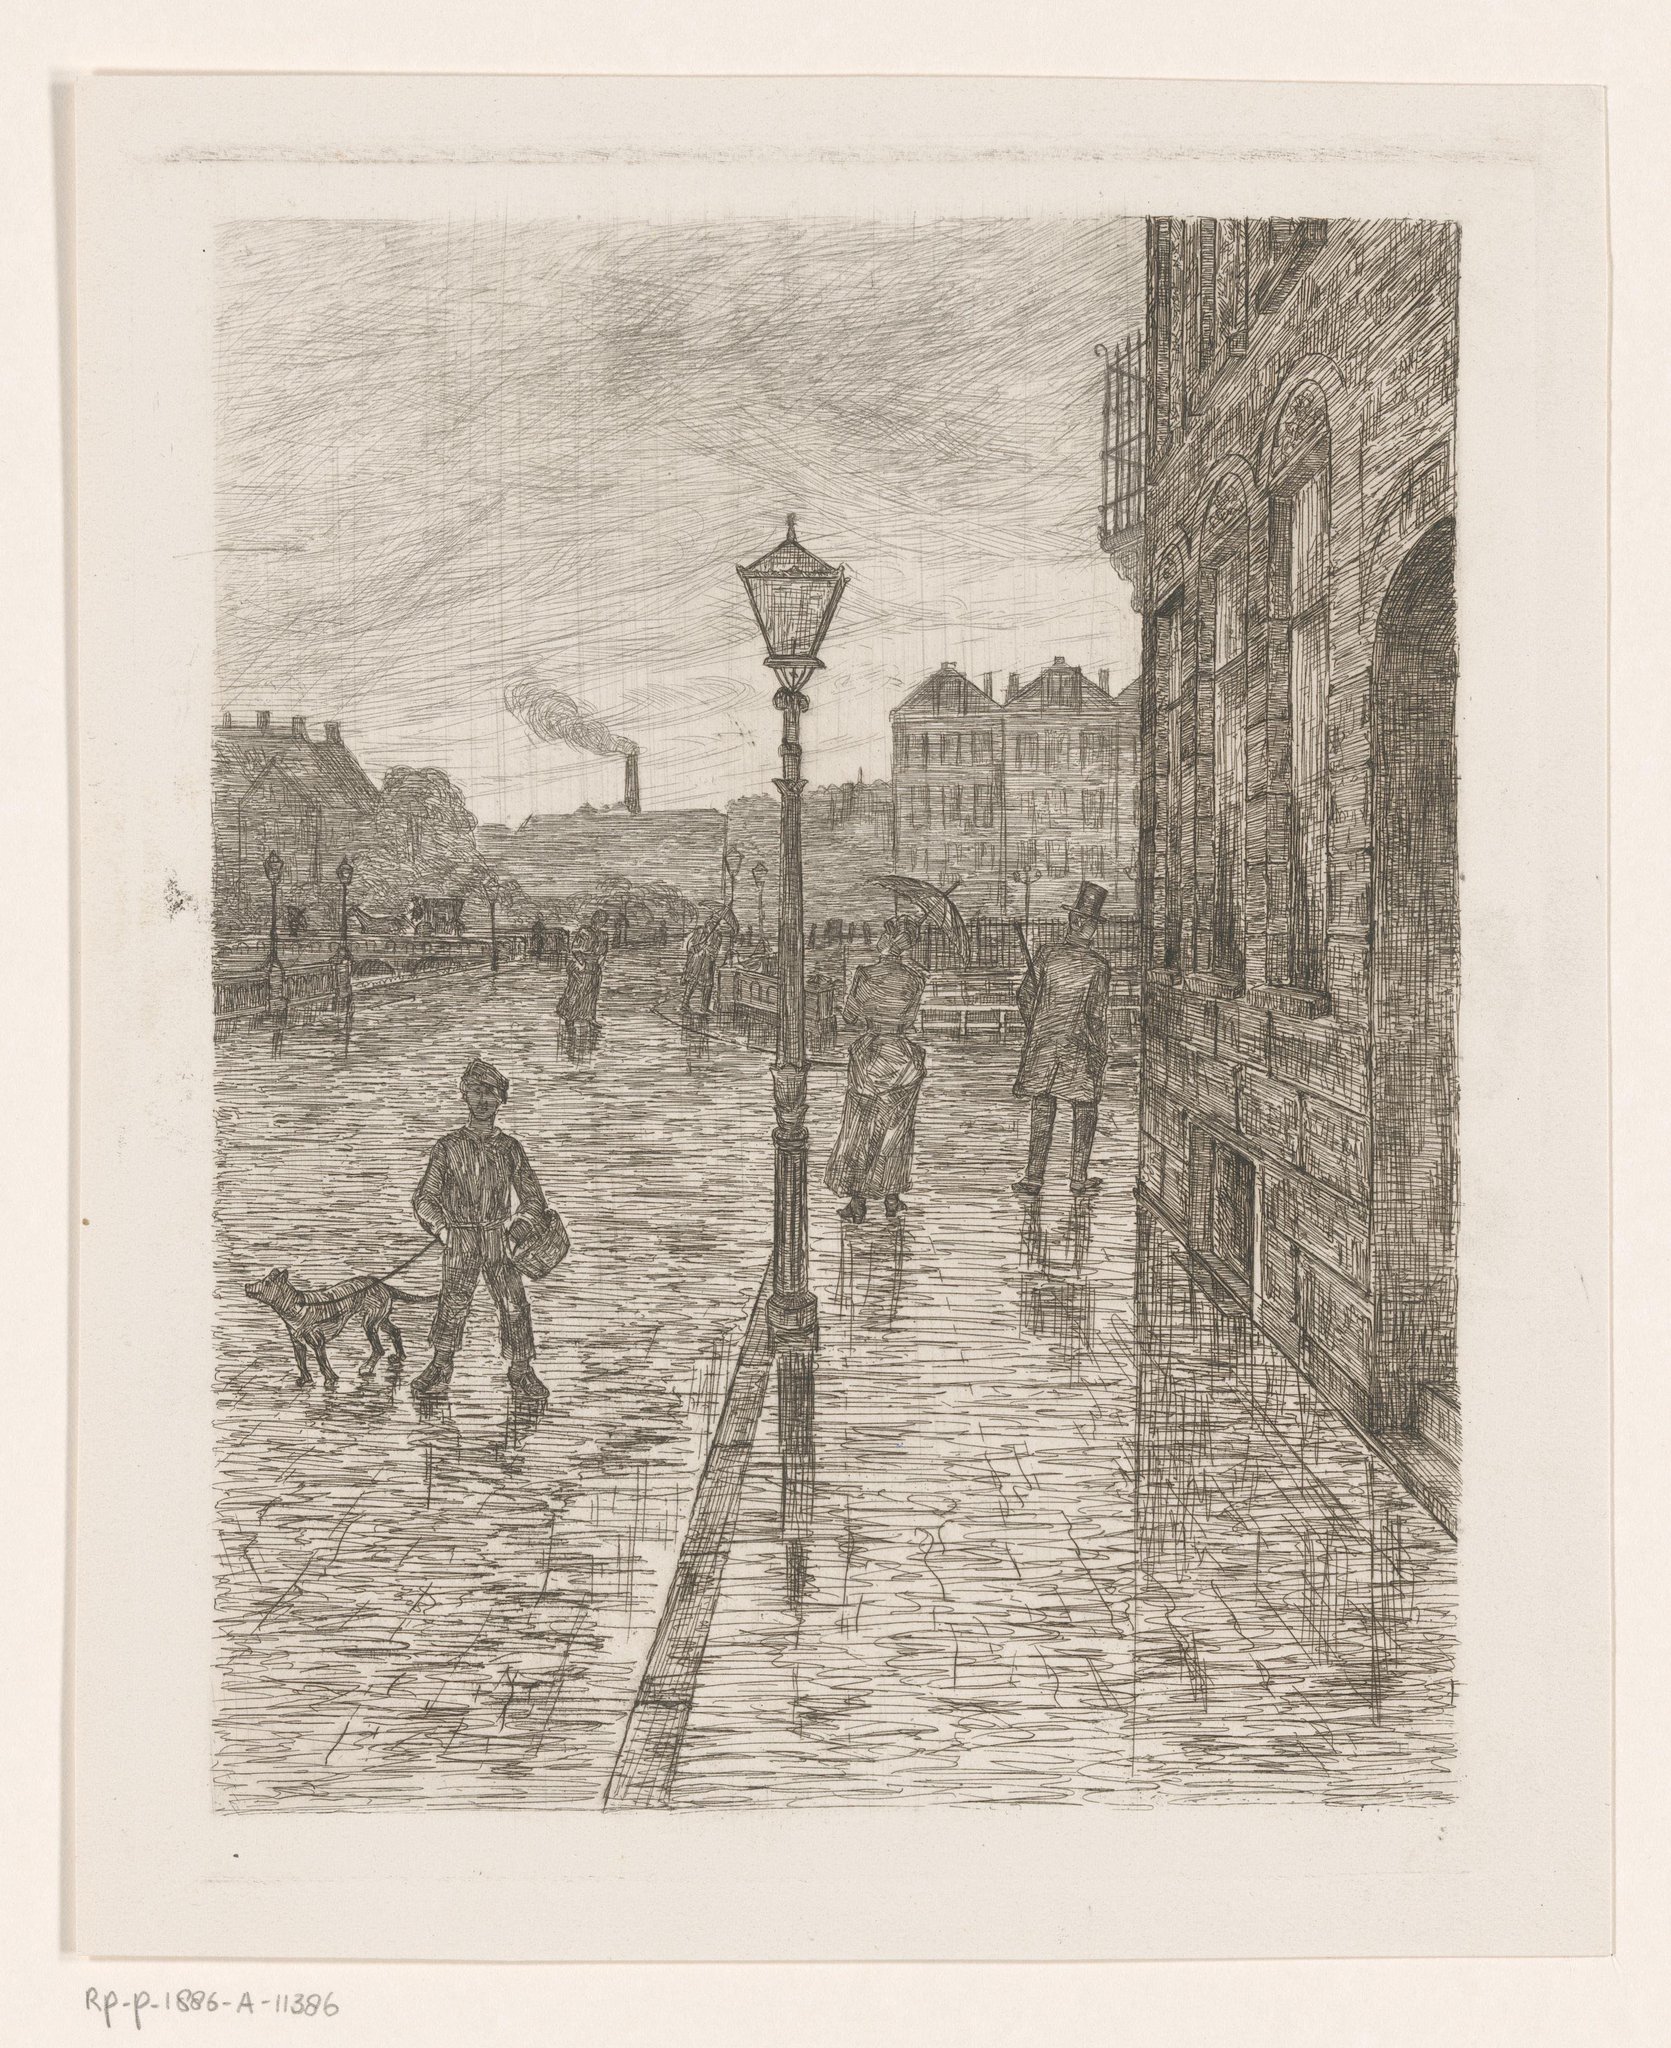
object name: print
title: Stadsgezicht bij regen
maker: egbert rubertus derk schaap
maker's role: draughtsman, painter, print maker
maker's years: 1862-1939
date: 1877-1886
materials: paper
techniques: etching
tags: city-view, and landscape with man-made constructions, city dwellers, dog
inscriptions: collector's mark: Lugt 2228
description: Links op de voorgrond loopt een jongen met een hond. Rechts loopt een man met een hoed en links daarvan een vrouw met een paraplu.